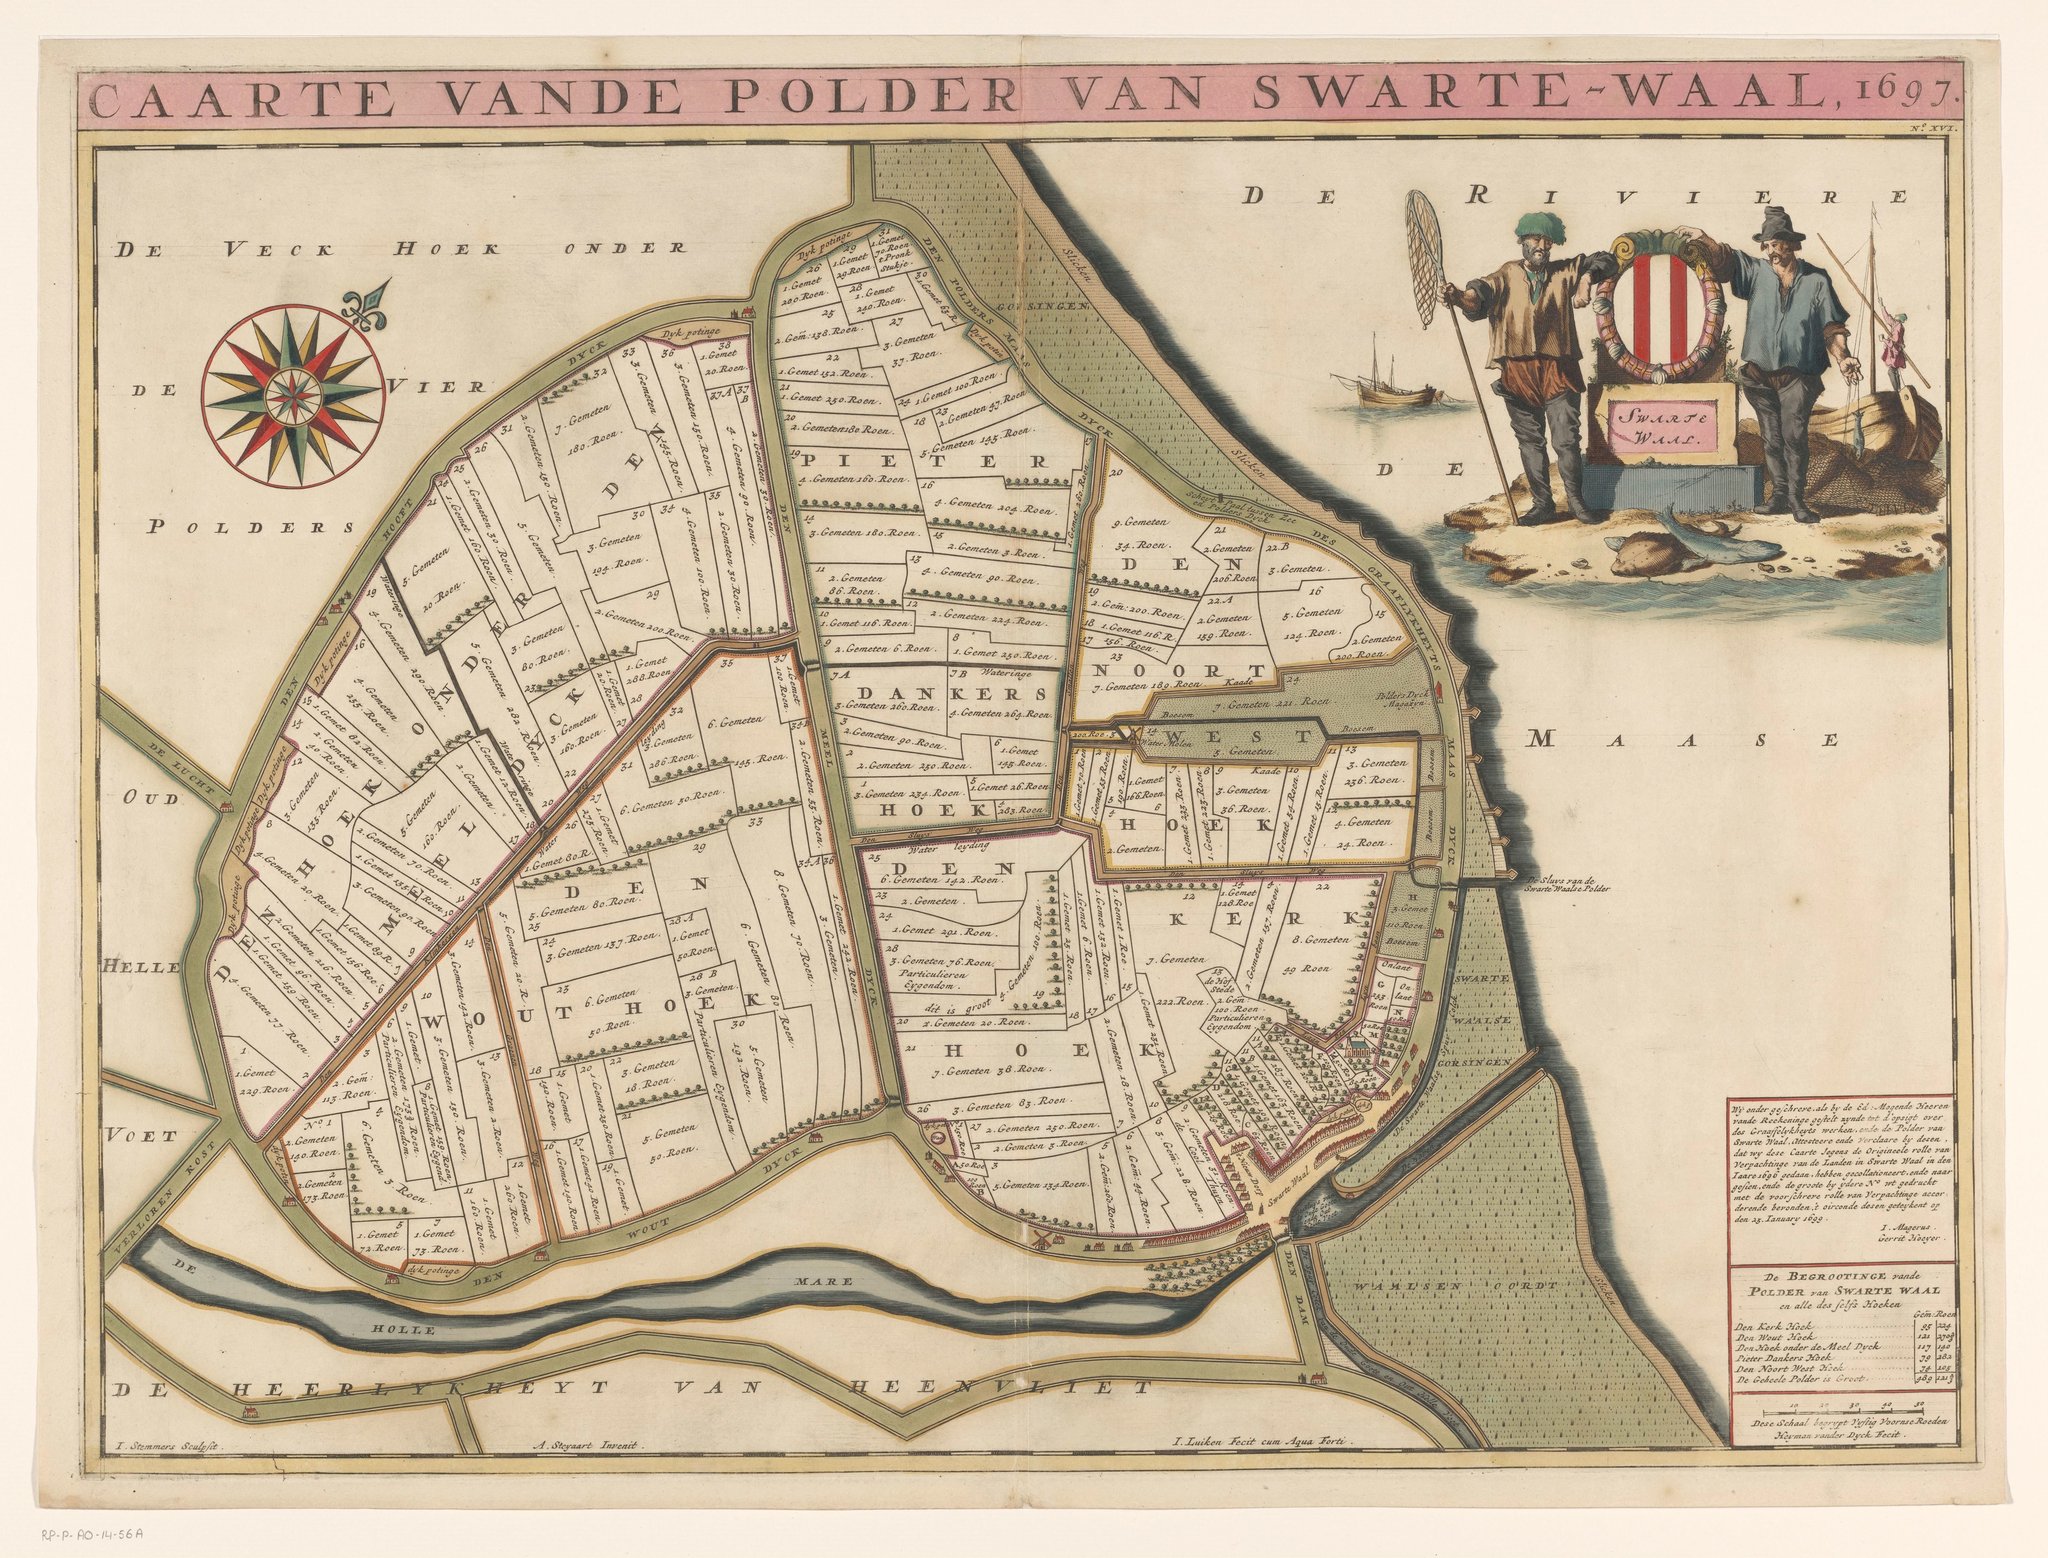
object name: map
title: Voorne Caart-boeck / Caartboeck van Voorne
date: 1701-1729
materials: paper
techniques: engraving, etching, hand coloring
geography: amsterdam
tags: coat of arms (as symbol of the state, etc.), maps of separate countries or regions, fisherman showing catch, polder, reclaimed land, fisherman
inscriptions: collector's mark: Lugt 19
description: Deze kaart is onderdeel van het zogenaamde 'Voorne Caart-boeck' / 'Caartboeck van Voorne', dat bestaat uit een titelpagina (zie RP-P-1942-347), drie algemene kaarten (van Oost-, West- en Zuid-Voorne)* en dertig detailkaarten. Het kaartboek werd vervaardigd in opdracht van de Staten van Voorne en werd in 1701 uitgegeven. Een deel van de koperplaten is bewaard gebleven en in de negentiende en twintigste eeuw gebruikt voor herdrukken. *Over de naam Voorne kan verwarring ontstaan omdat de betekenis door de eeuwen heen is veranderd. Vroeger stonden de (voormalige) eilanden Voorne, Goeree en Overflakkee – allen historisch gezien onderdeel van het Land van Voorne – bekend als respectievelijk Oost-, West- en Zuid-Voorne. Afdrukken van de drie algemene kaarten, waaronder deze kaart, zijn ook gebruikt in: Alkemade, Cornelis van en Pieter van der Schelling. Beschryving van de Stad Brielle, en den lande van Voorn (…). Rotterdam: Philippus Losel, 1729.